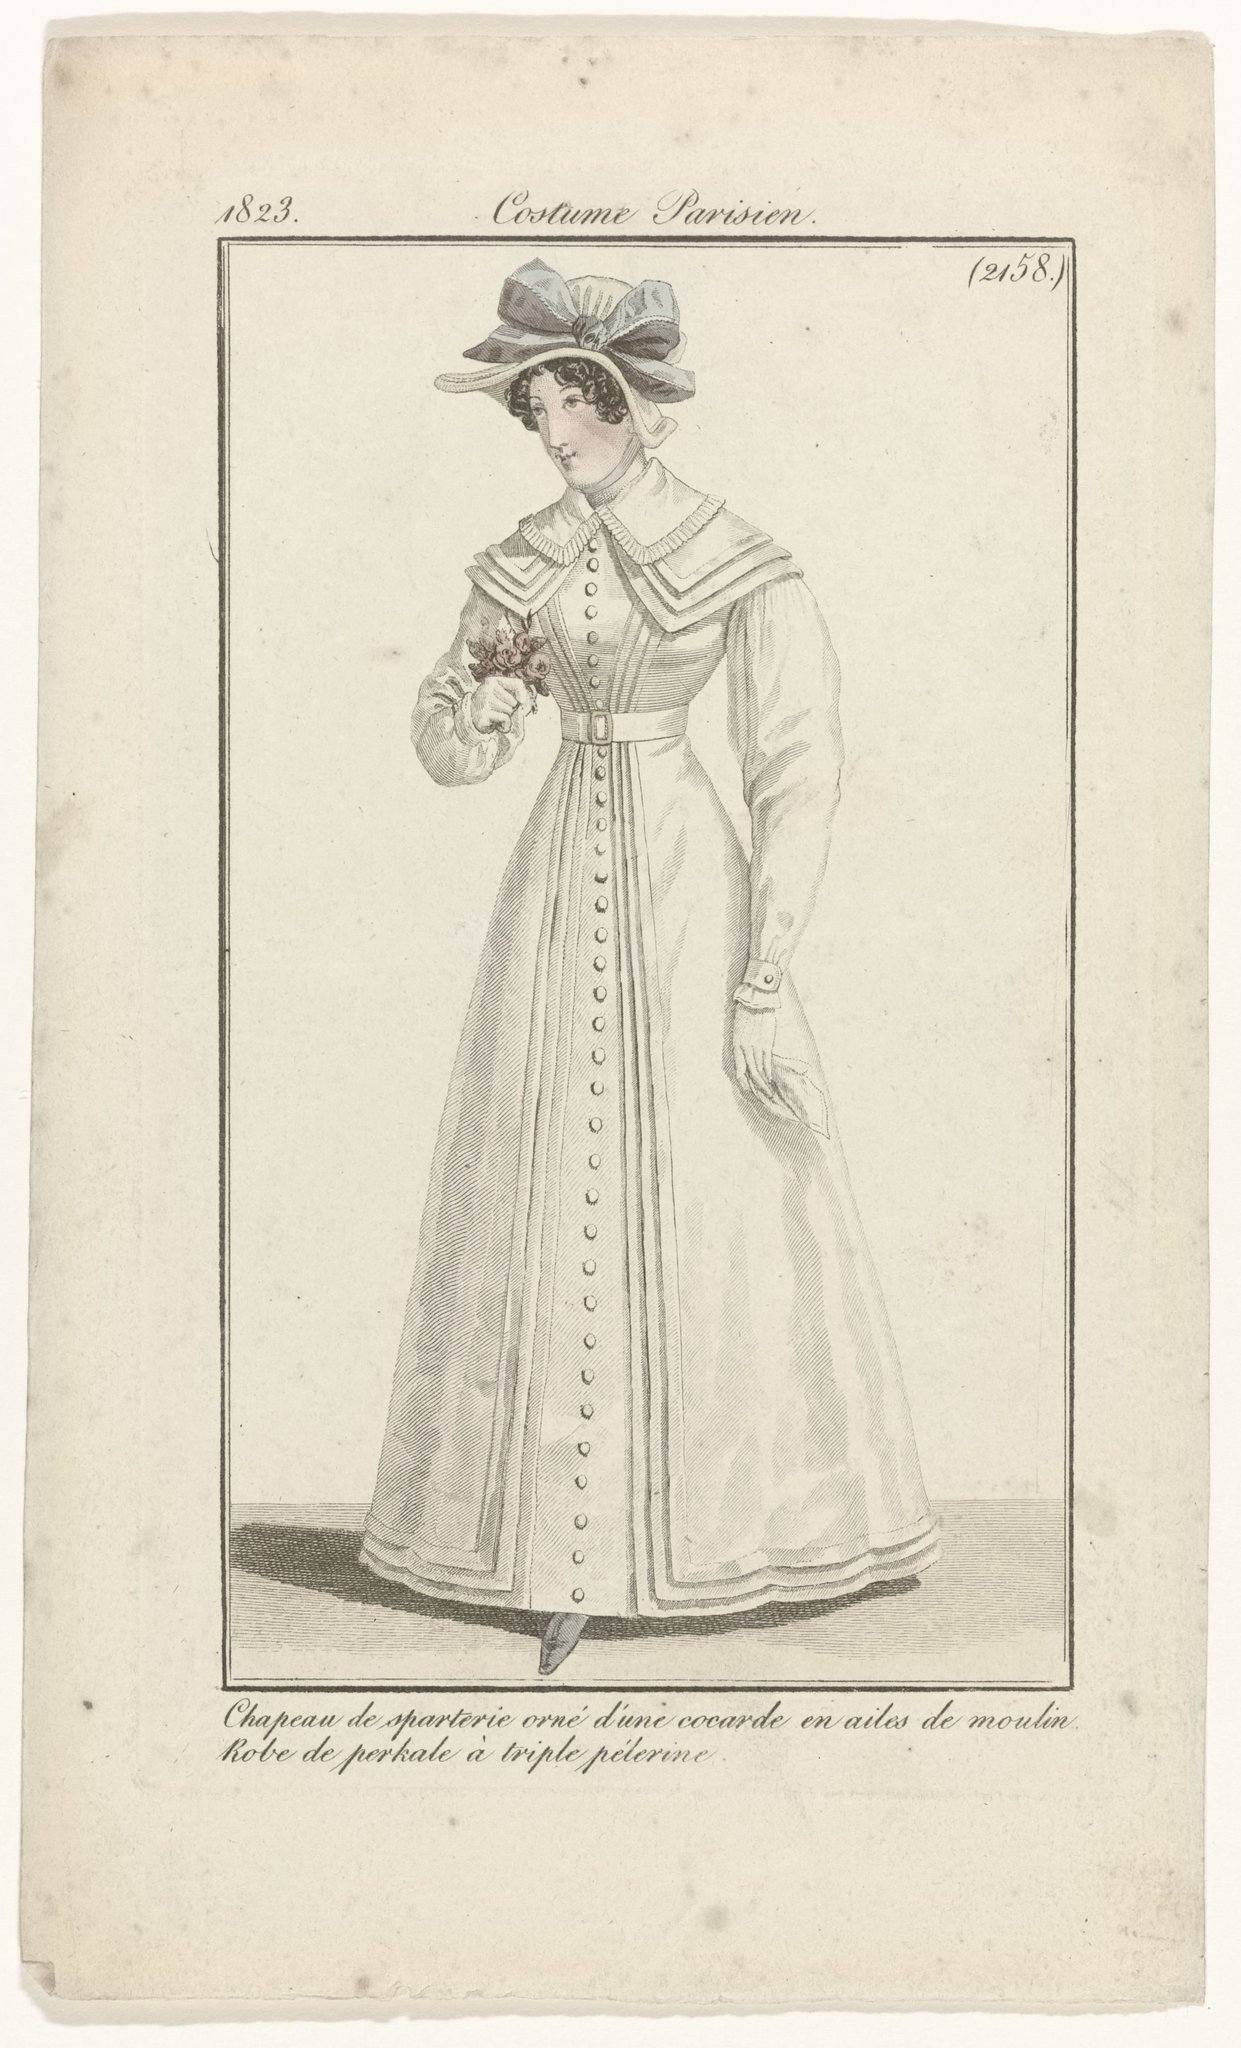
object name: fashion print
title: Journal des Dames et des Modes, Costumes Parisiens, 1823, (2158): Chapeau de sparteri (...)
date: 1823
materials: paper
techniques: engraving, hand coloring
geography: paris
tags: handkerchief (+ women's clothes), cut flowers; nosegay, bunch of flowers, clothing for the upper part of the body (mantelet) (+ women's clothes), fashion plates, head-gear: hat (+ women's clothes), dress, gown (+ women's clothes)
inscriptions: title: ‘Costume Parisien.’, caption: ‘Chapeau de sparterie orné d'une cocarde en ailes de moulin. Robe de perkale à triple pélerine.’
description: Staande vrouw gekleed in een japon van katoenbatist (percale) met een driedubbele pelerine. Op het hoofd een hoed van 'sparterie' (gevlochten plantenvezels) versierd met een kokarde 'en ailes de moulin'. De prent maakt deel uit van het modetijdschrift Journal des Dames et des Modes, uitgegeven door Pierre de la Mésangère, Parijs, 1797-1839.